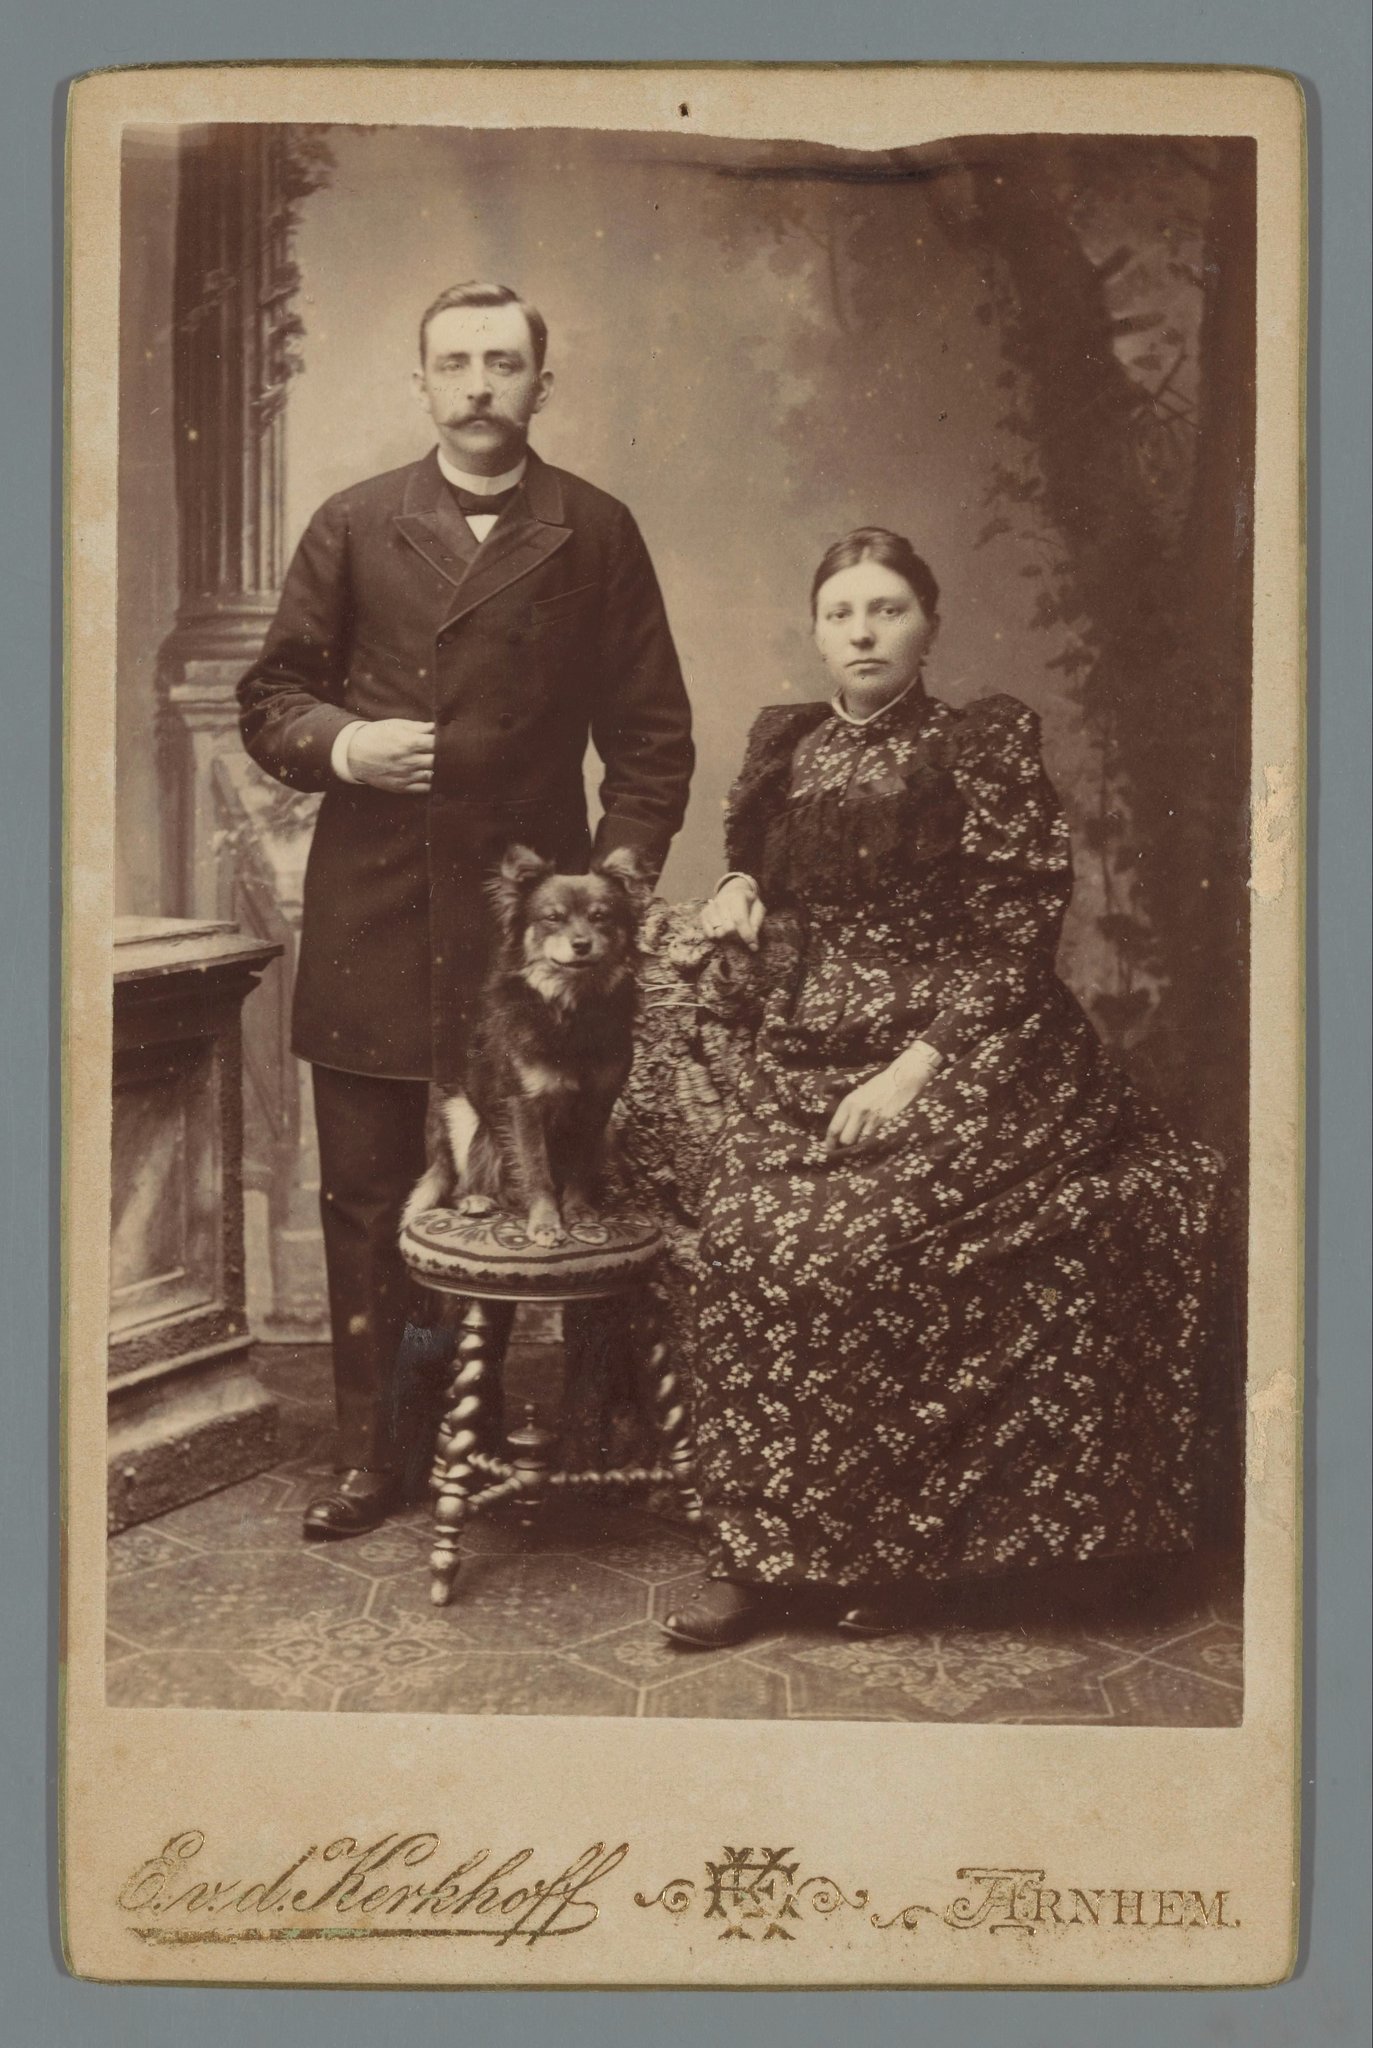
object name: cabinet photograph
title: Portret van een onbekende man en vrouw met een hond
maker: e. v.d. kerkhoff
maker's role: fotograaf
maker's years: 1861-1943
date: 1895-1908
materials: cardboard, photographic support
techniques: albumen print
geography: arnhem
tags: adult woman, studio requisites ~ photographer, adult man, dog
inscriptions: name: ‘Atelier E. v.d. Kerkhoff Arnhem Kippenmarkt No. 3. (...)’